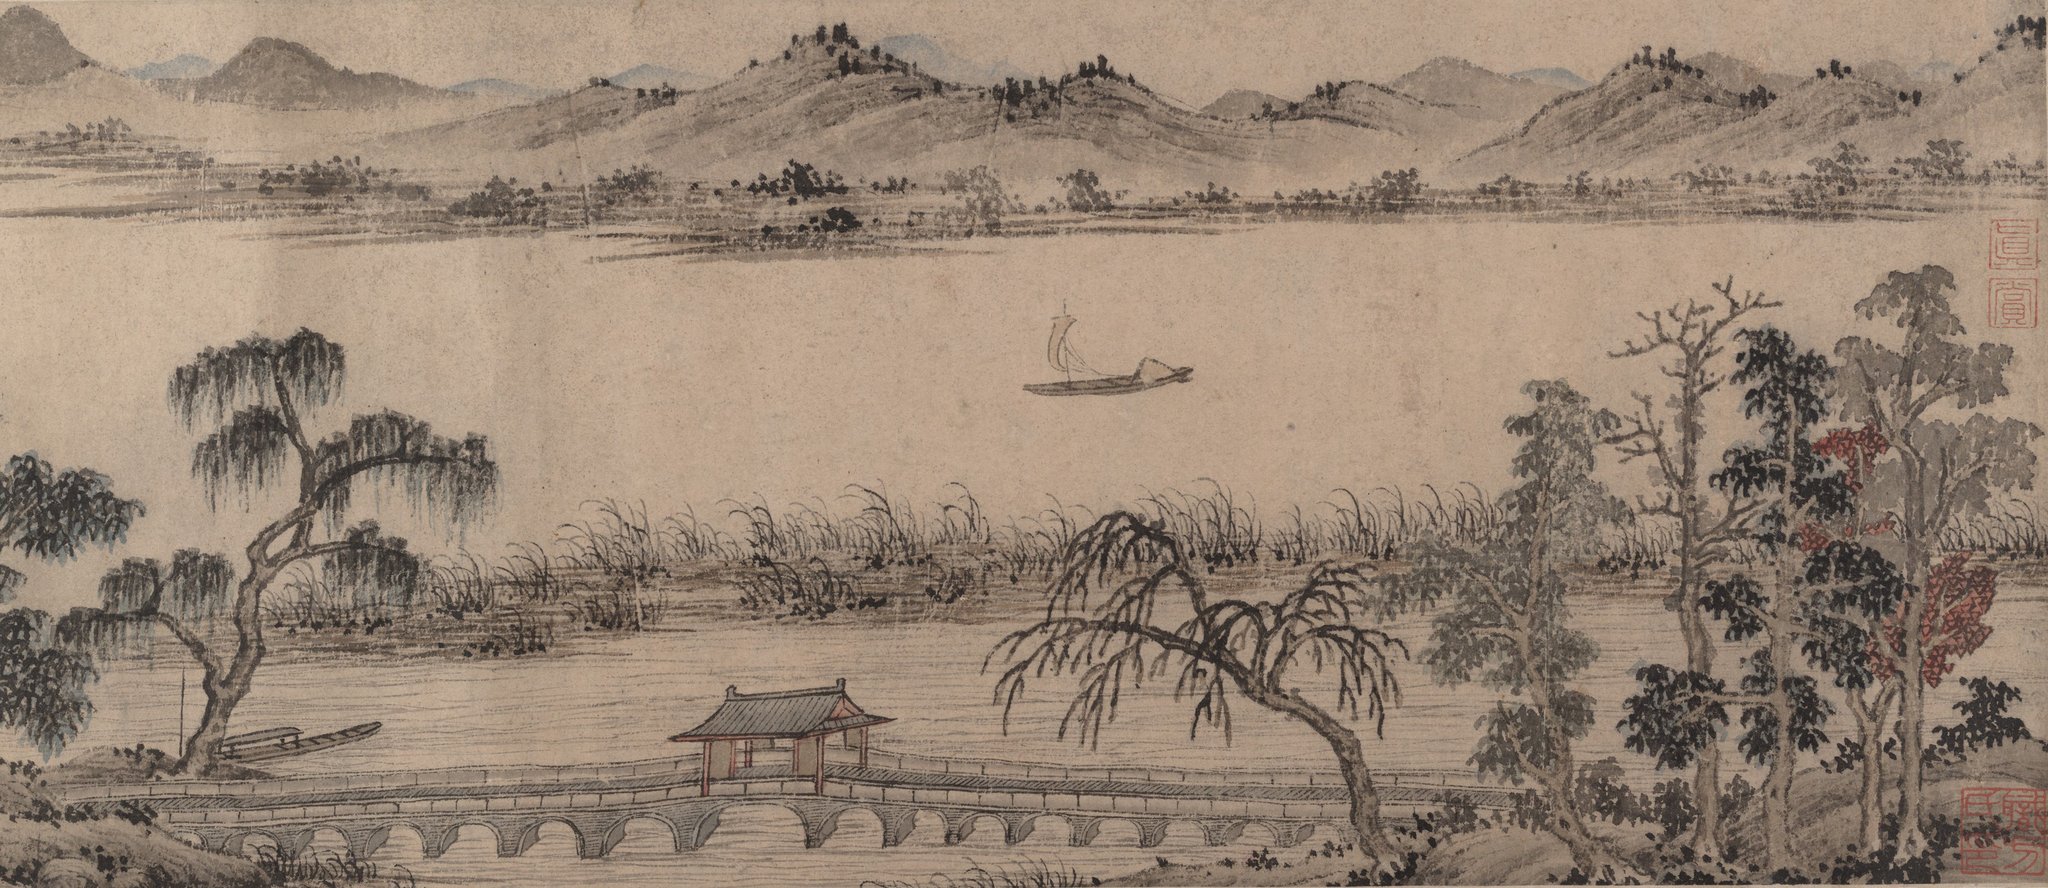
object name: handscroll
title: Pavilion of the Hovering Rainbow Bridge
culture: chinese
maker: unidentified artist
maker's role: artist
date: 1501-1600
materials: ink, paper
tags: bridges,rivers,landscapes,boats